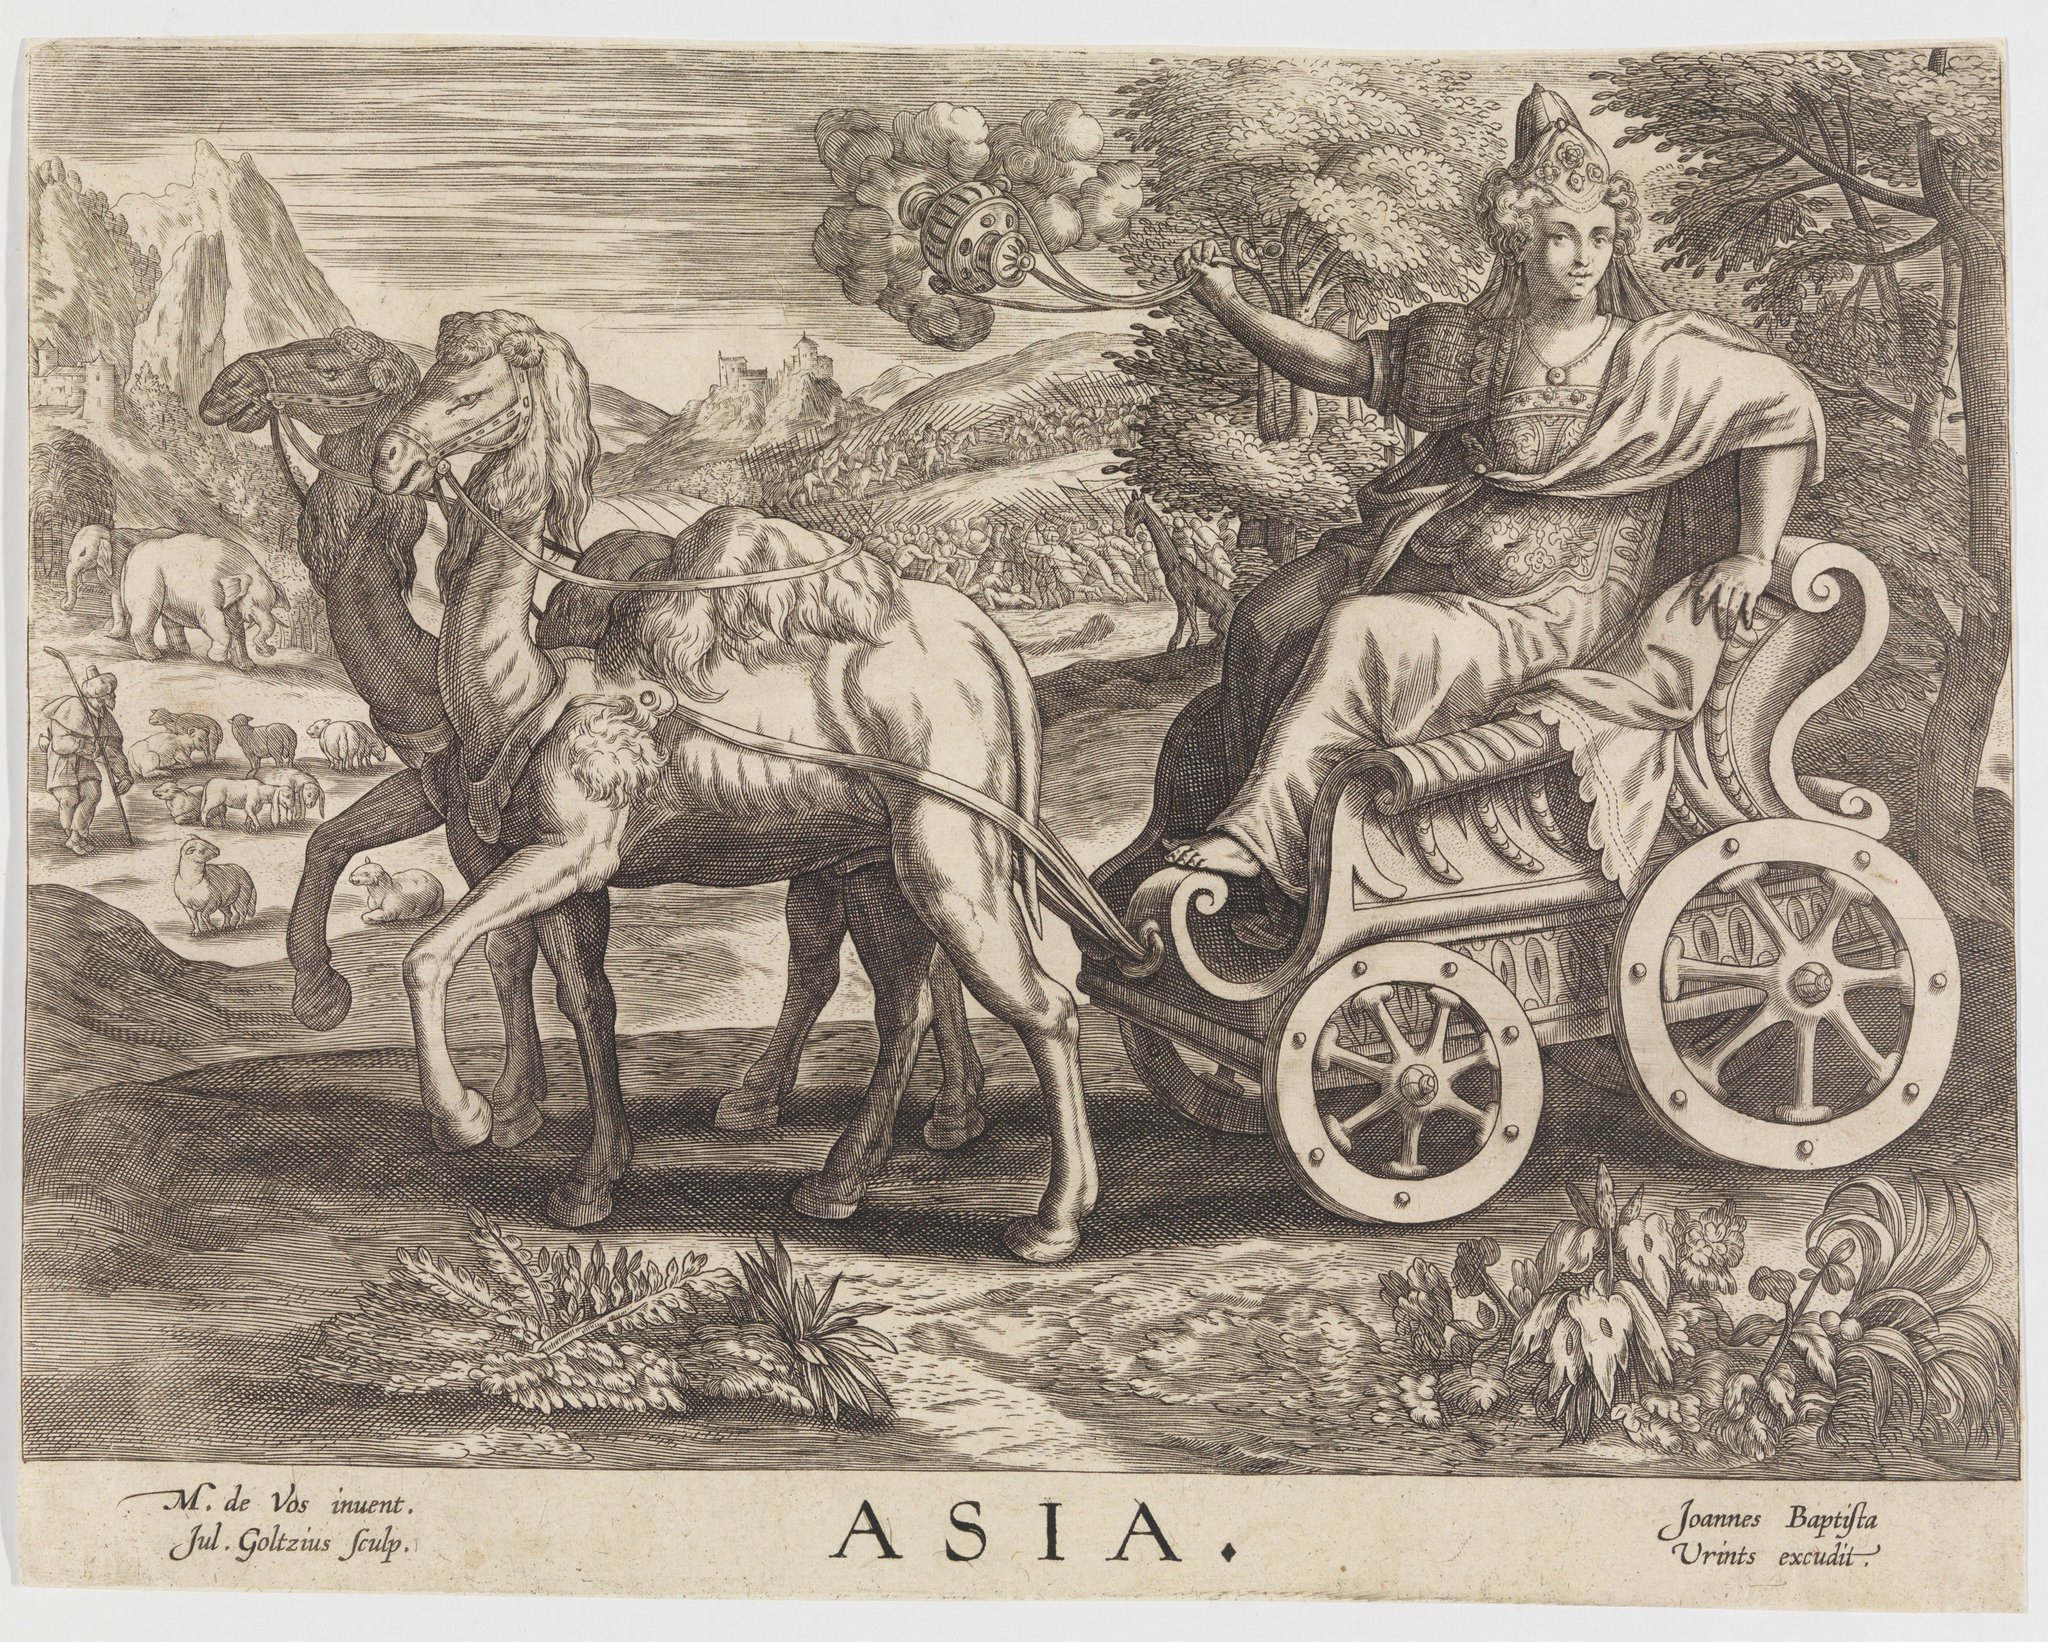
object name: print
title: Allegory of Asia, from "The Four Continents"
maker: julius goltzius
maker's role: engraver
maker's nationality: netherlandish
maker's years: 1500-1595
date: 1560-1590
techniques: engraving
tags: women,camels,elephants,chariots